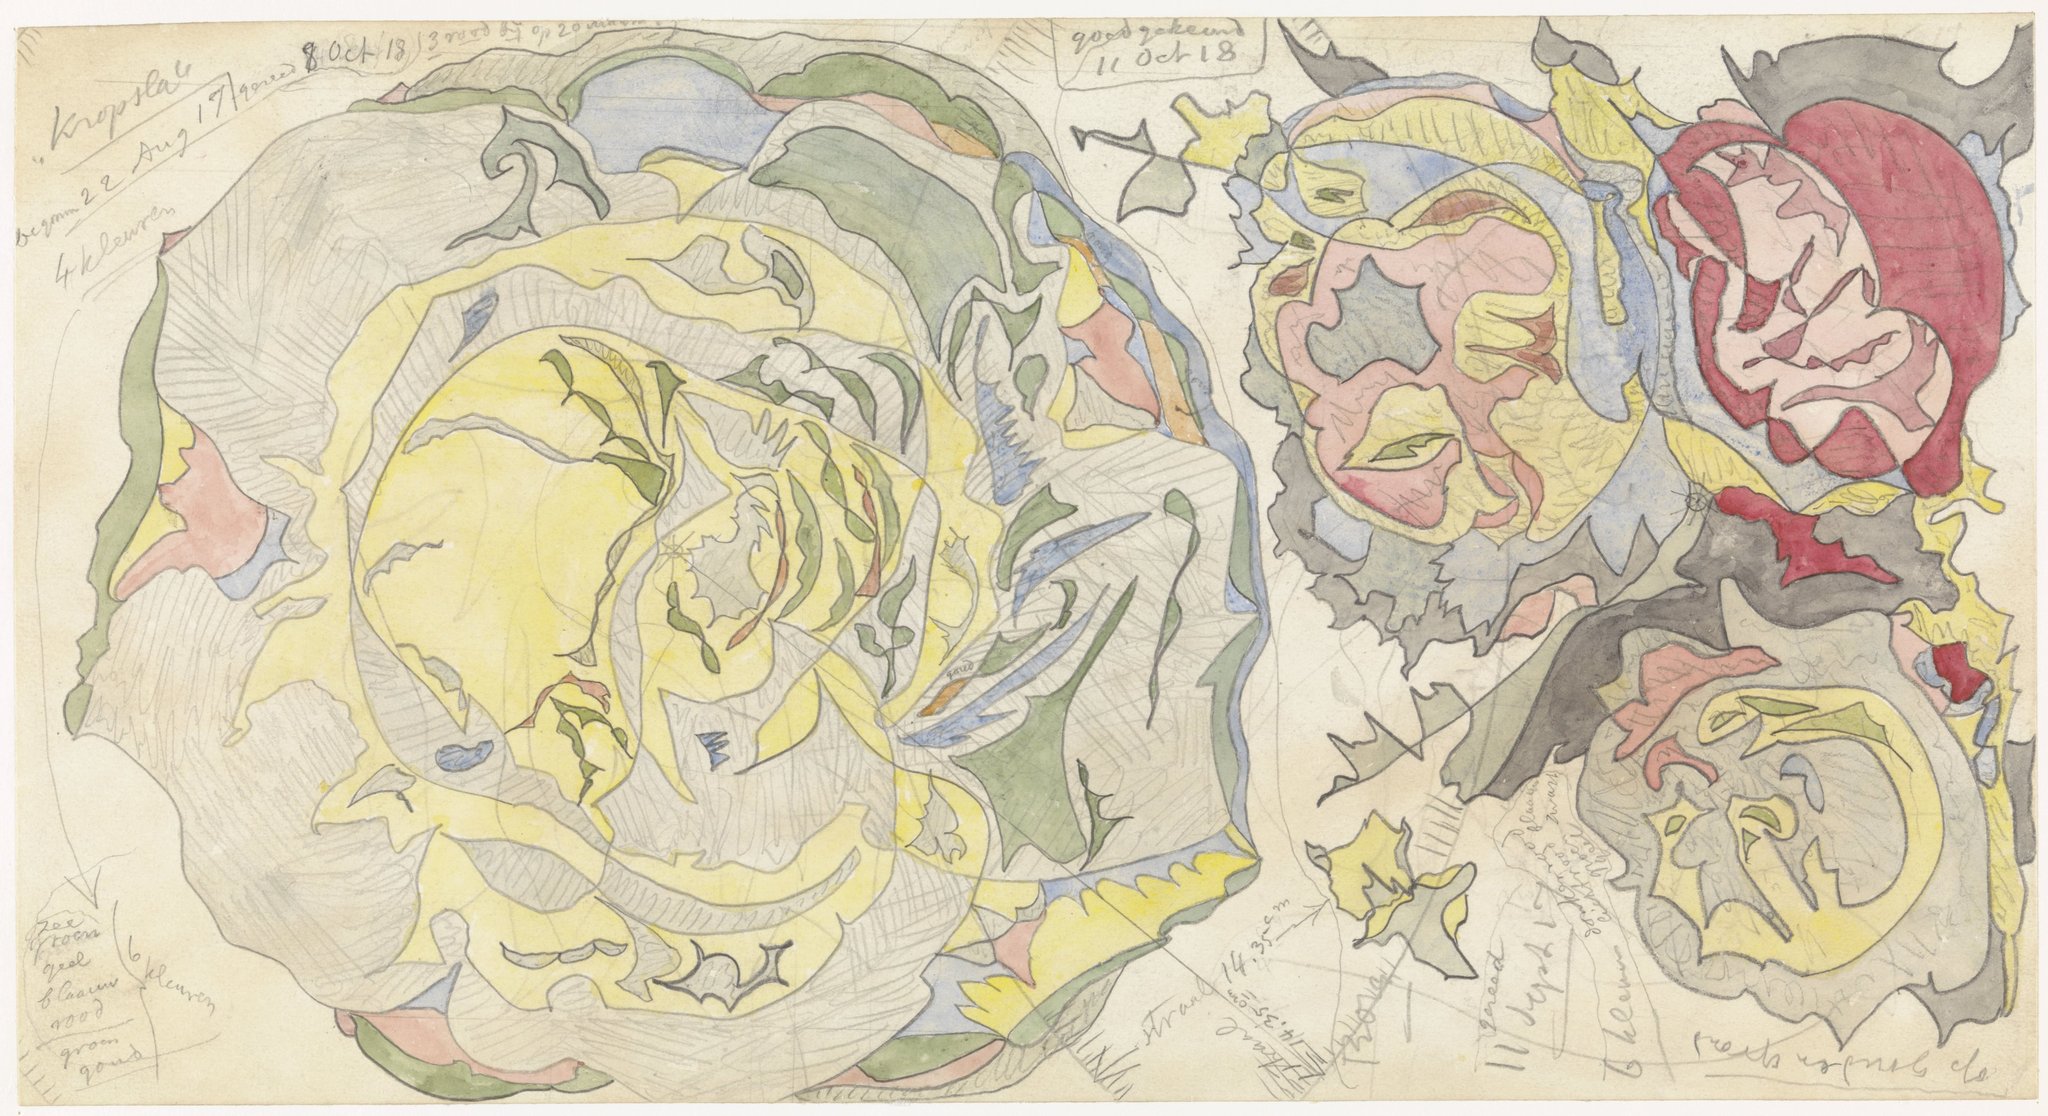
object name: drawing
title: Kropsla en bloemmotieven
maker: theo colenbrander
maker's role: draughtsman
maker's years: 1841-1930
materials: paper, pencil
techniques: brush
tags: flowers, vegetables (with name)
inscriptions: date: ‘begonnen 22 Aug 17 gereed 8 Oct 18’